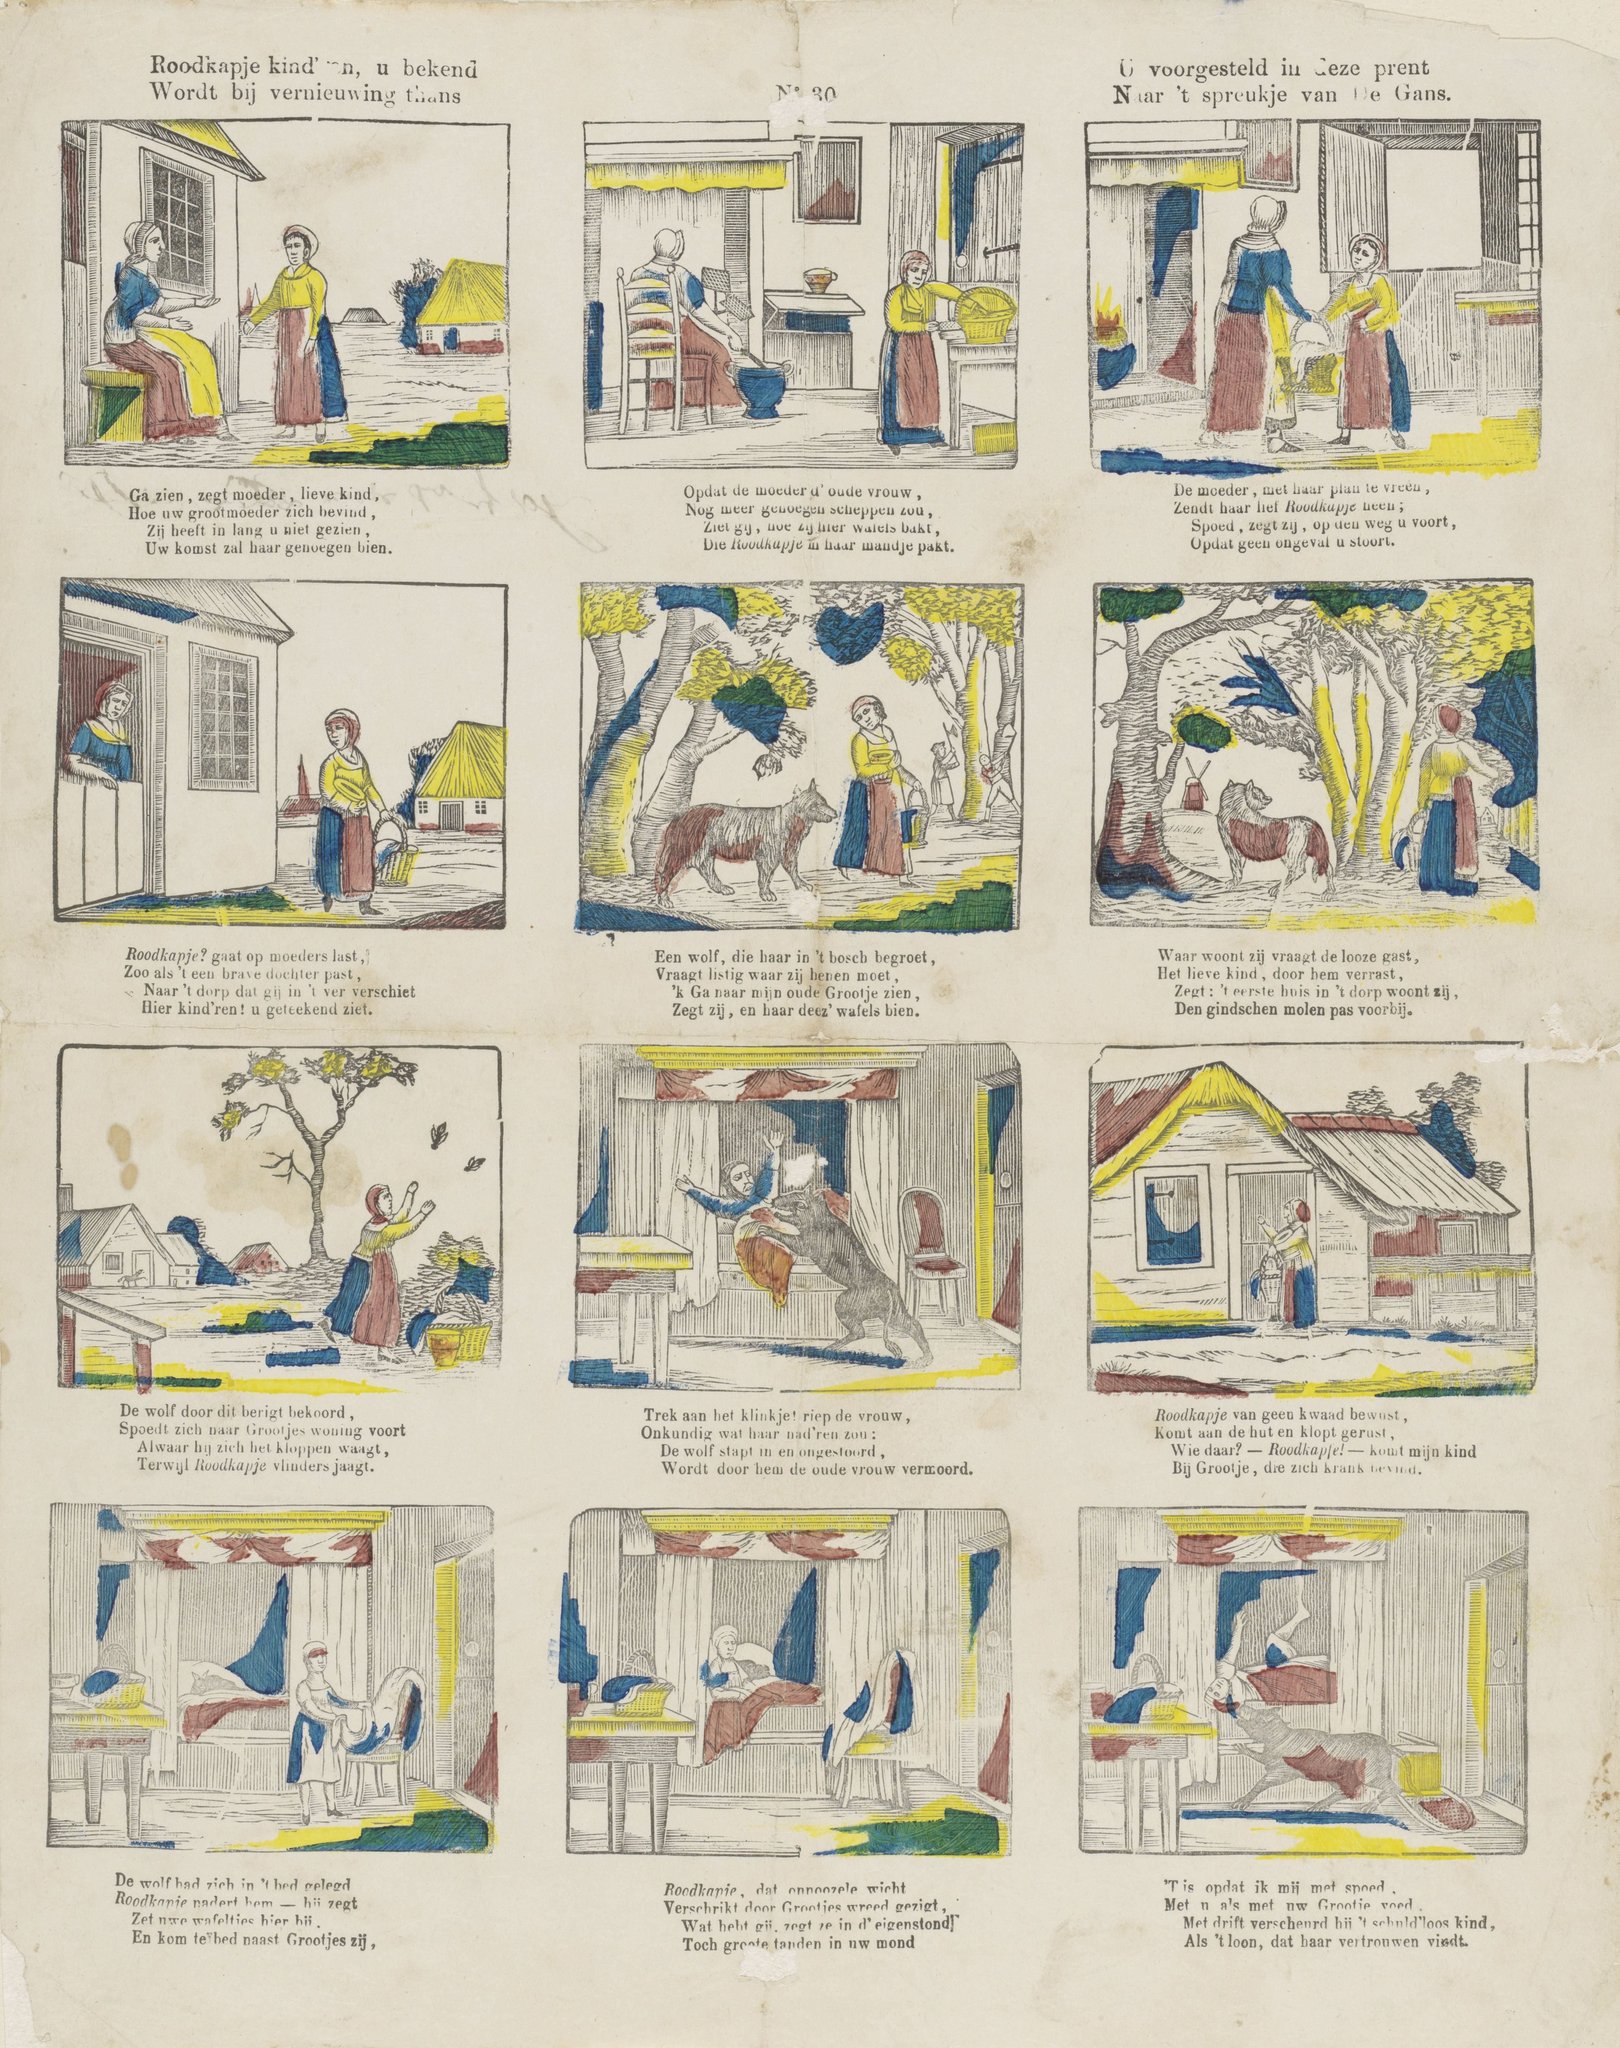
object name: popular print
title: Roodkapje kind'ren, u bekend / Wordt bij vernieuwing thans / U voorgesteld in deze prent / Naar 't spreukje van de gans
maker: Anonymous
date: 1848-1881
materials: paper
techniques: colour, letterpress printing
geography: netherlands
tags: tales and fairy tales: little red riding-hood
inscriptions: inscription: ‘Jakop [...]’, collector's mark: Lugt 2228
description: Blad met 12 voorstellingen uit het sprookje van Roodkapje. Onder elke voorstelling een vierregelig vers. Genummerd midden boven: No. 30.